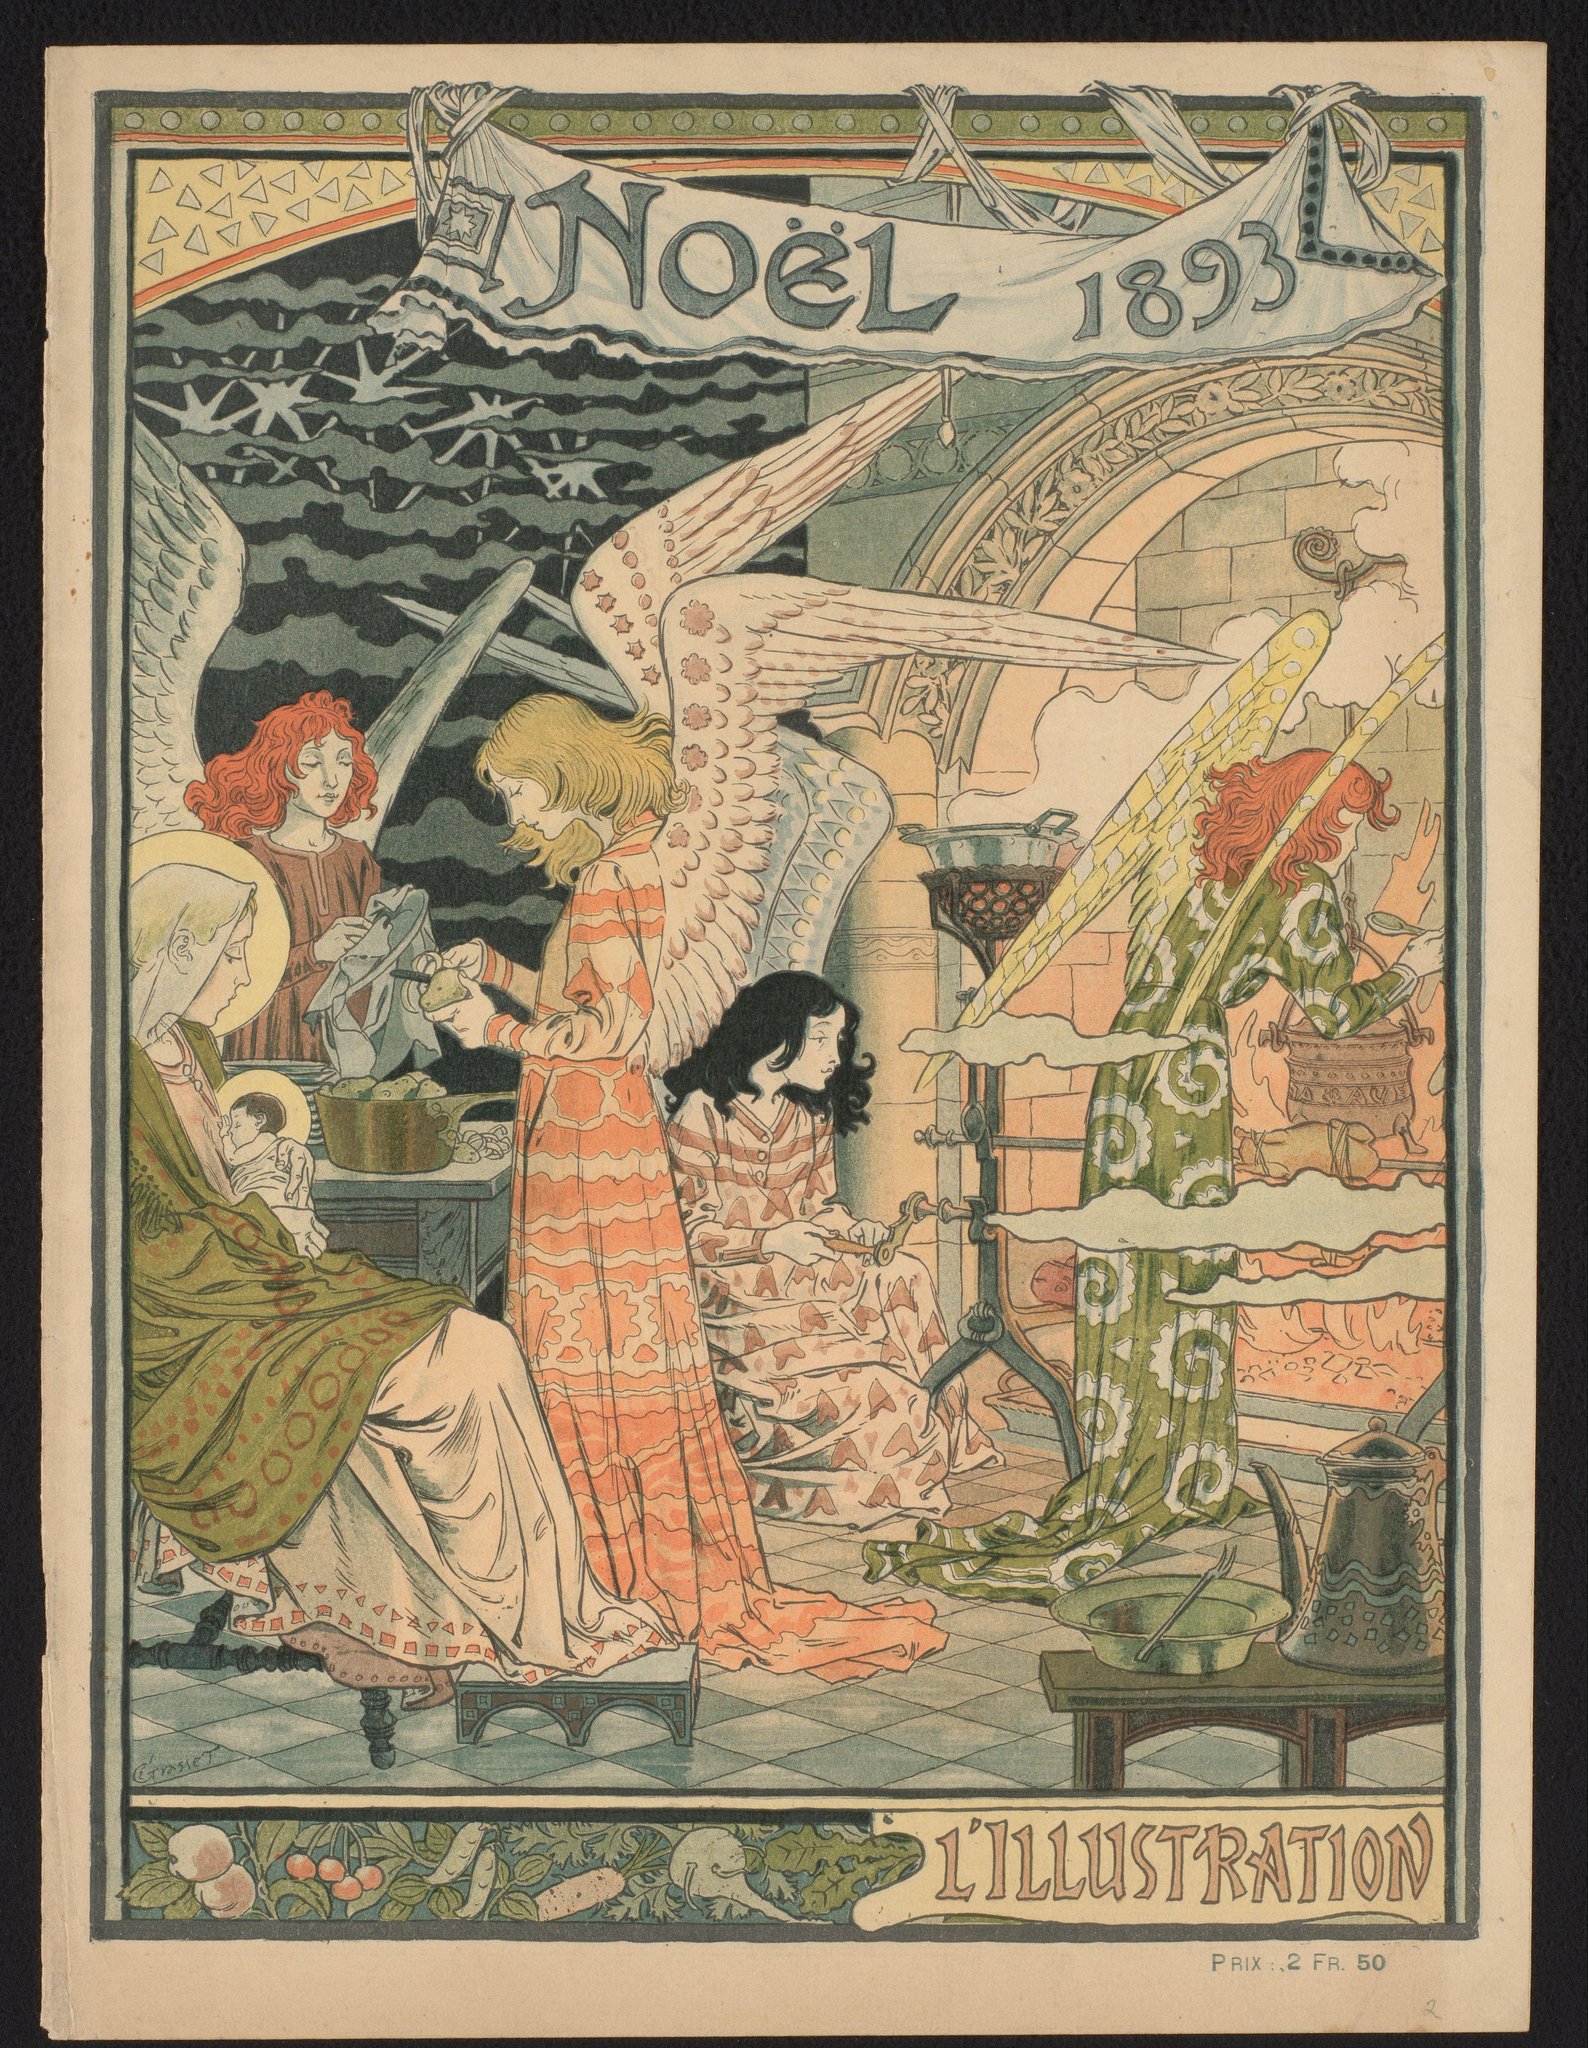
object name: wrapper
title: Omslag voor het Kerstnummer 1893 van 'l'Illustration'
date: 1893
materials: paper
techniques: lithograph, letterpress printing, printing block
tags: christmas (non-liturgical celebration), weekly, monthly, magazine, etc., book-cover, binding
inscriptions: date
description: Maria met kind in een keuken waar vier engelen eten bereiden.